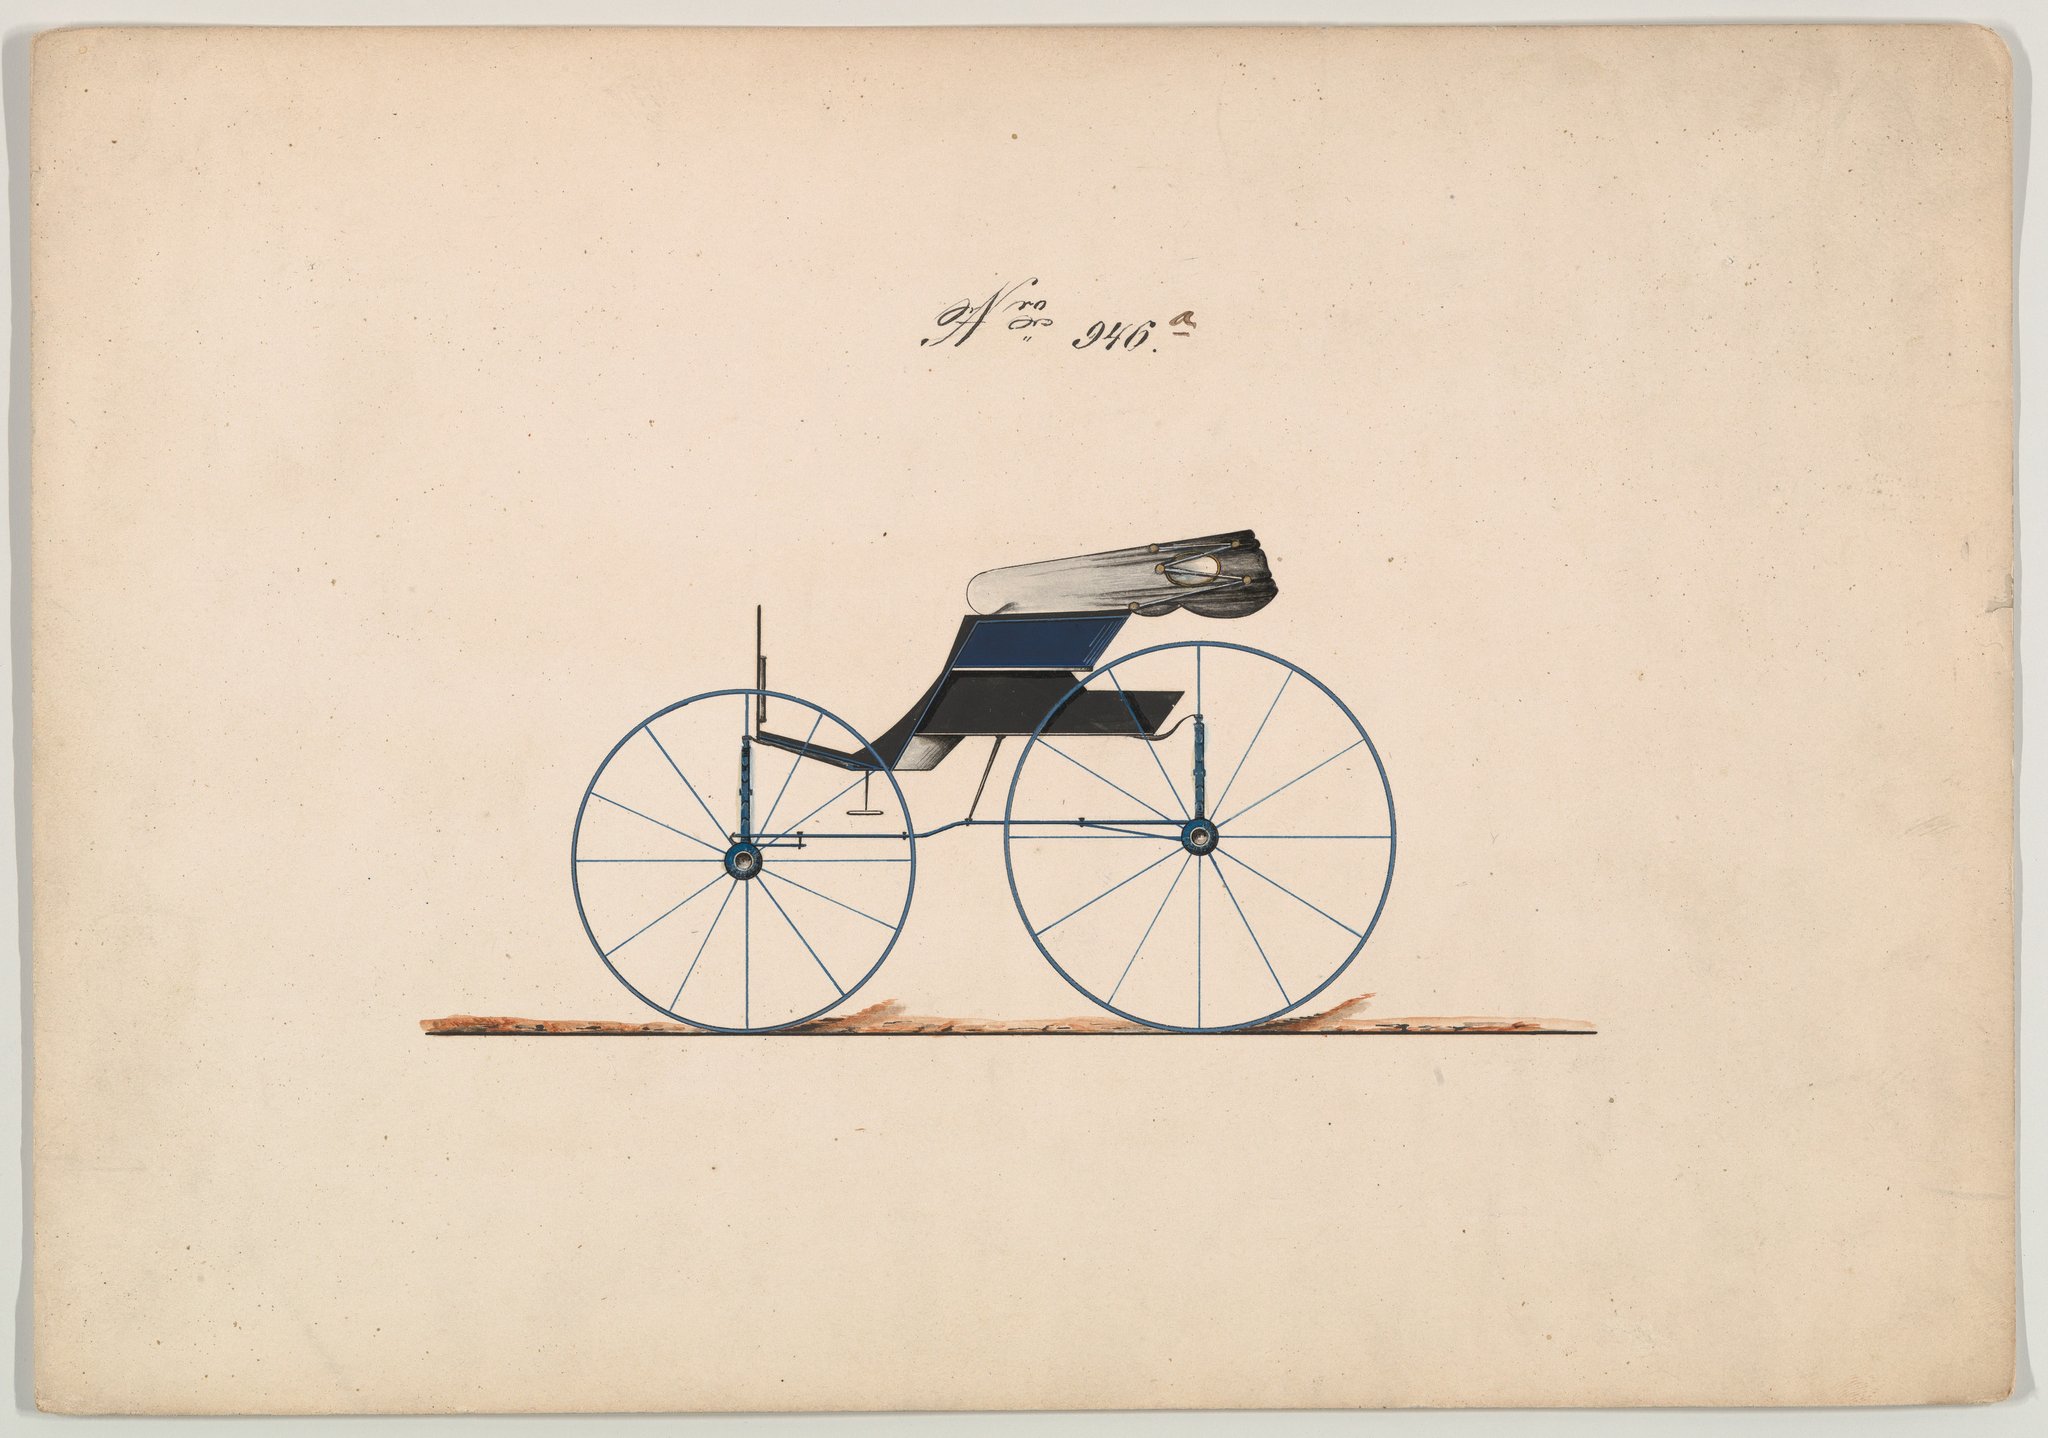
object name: drawing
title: Design for Wagon, no. 946a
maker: brewster & co.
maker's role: manufacturer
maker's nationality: american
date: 1850-1870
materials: gouache, gum arabic, ink, watercolor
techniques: pen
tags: carriages